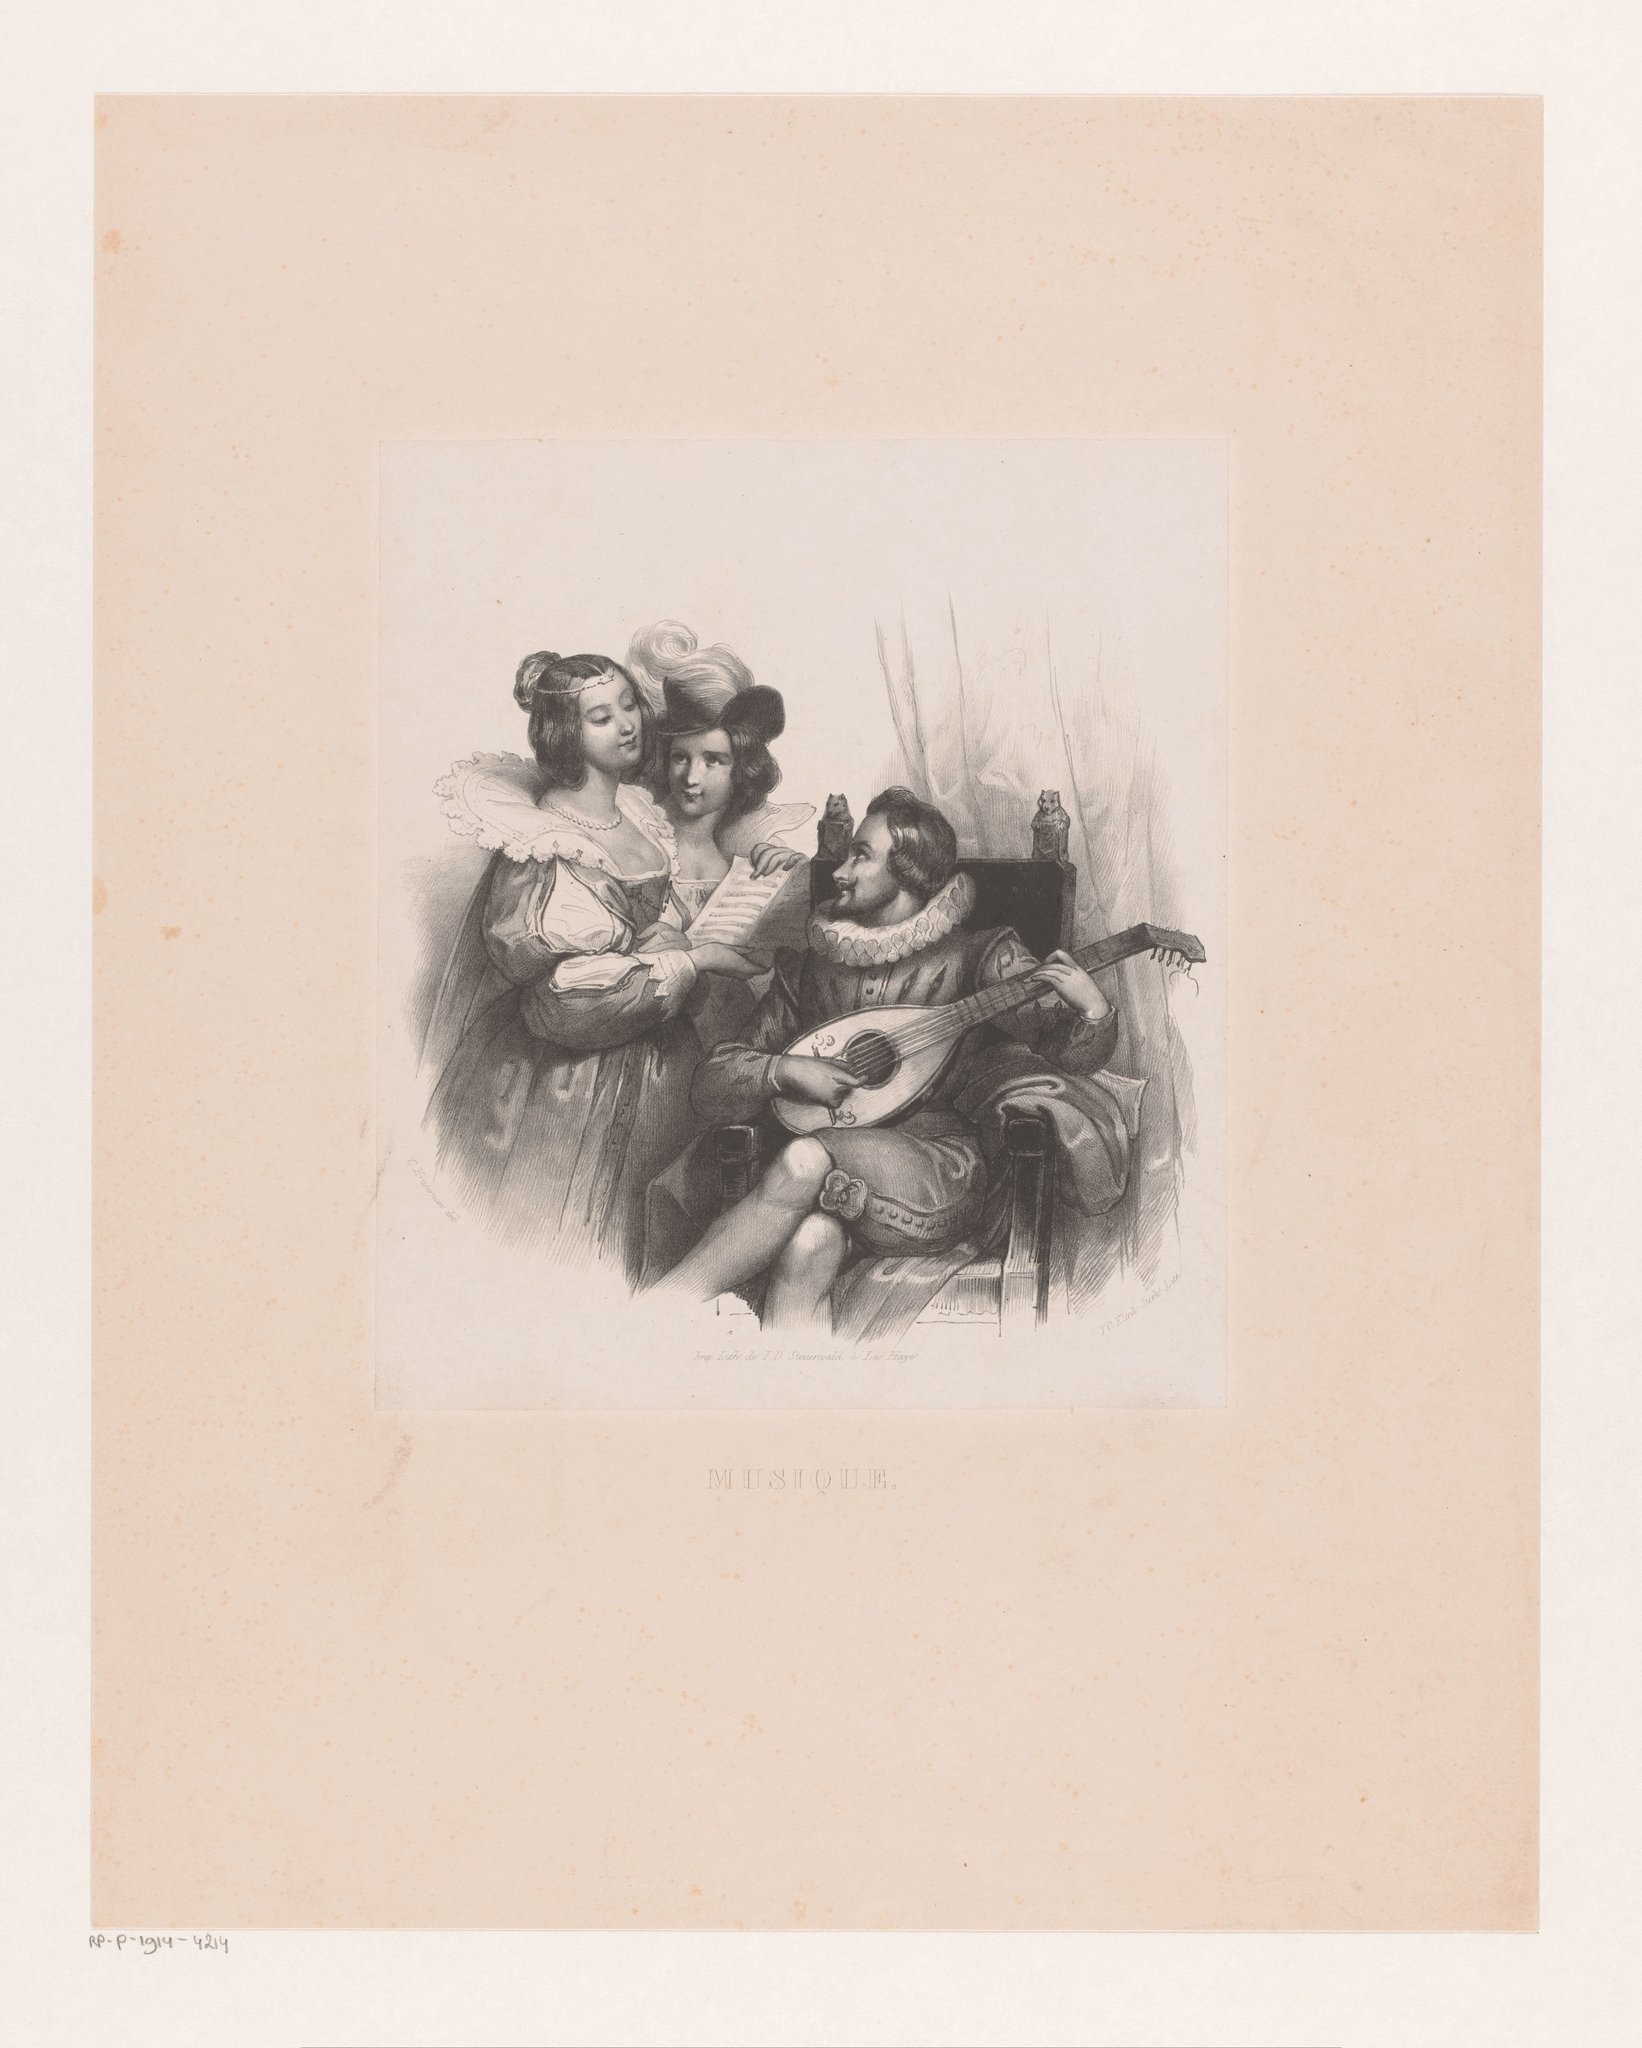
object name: print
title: Musicerend gezelschap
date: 1833-1863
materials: paper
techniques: lithograph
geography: the hague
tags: manuscript of musical score, musician(s) accompanying singer(s), lute, and special forms of lute, e.g.: theorbo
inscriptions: collector's mark: Lugt 2228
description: De man zit in een stoel met een luit in zijn armen. Naast hem staan twee vrouwen met bladmuziek.